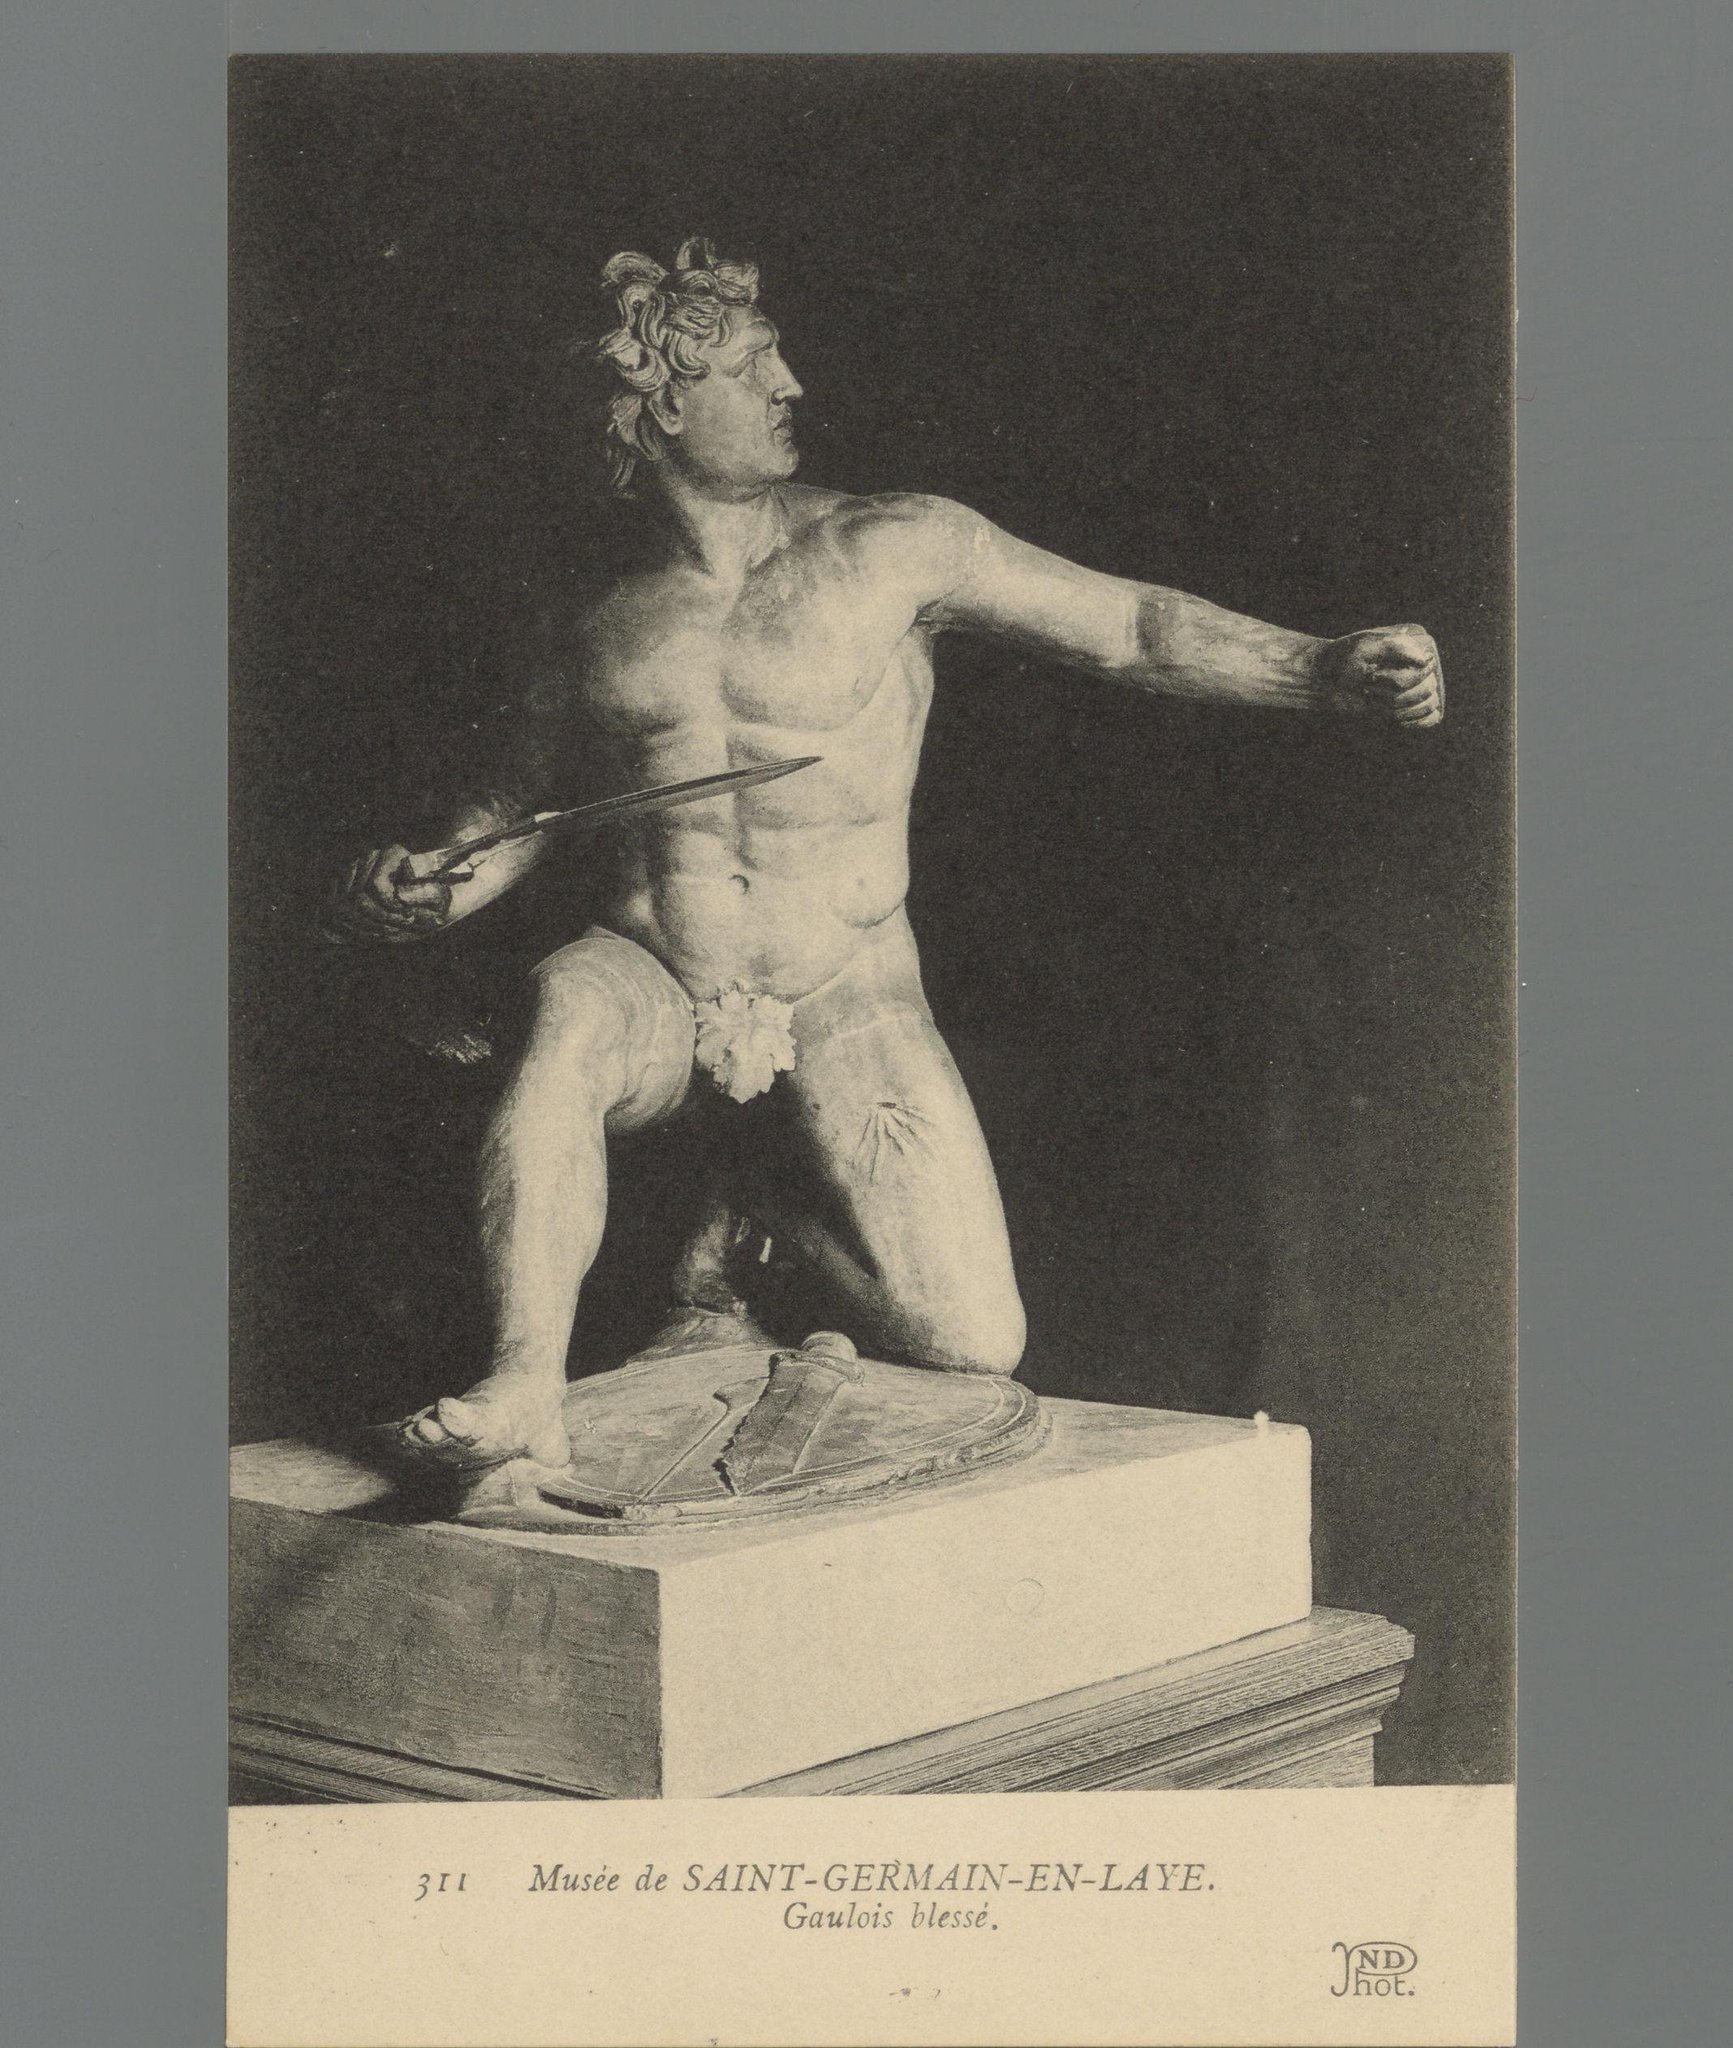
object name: photomechanical print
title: Gaulois blessé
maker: Anonymous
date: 1903-1918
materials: cardboard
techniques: photograph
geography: paris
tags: monument, statue, permanent exhibition, museum